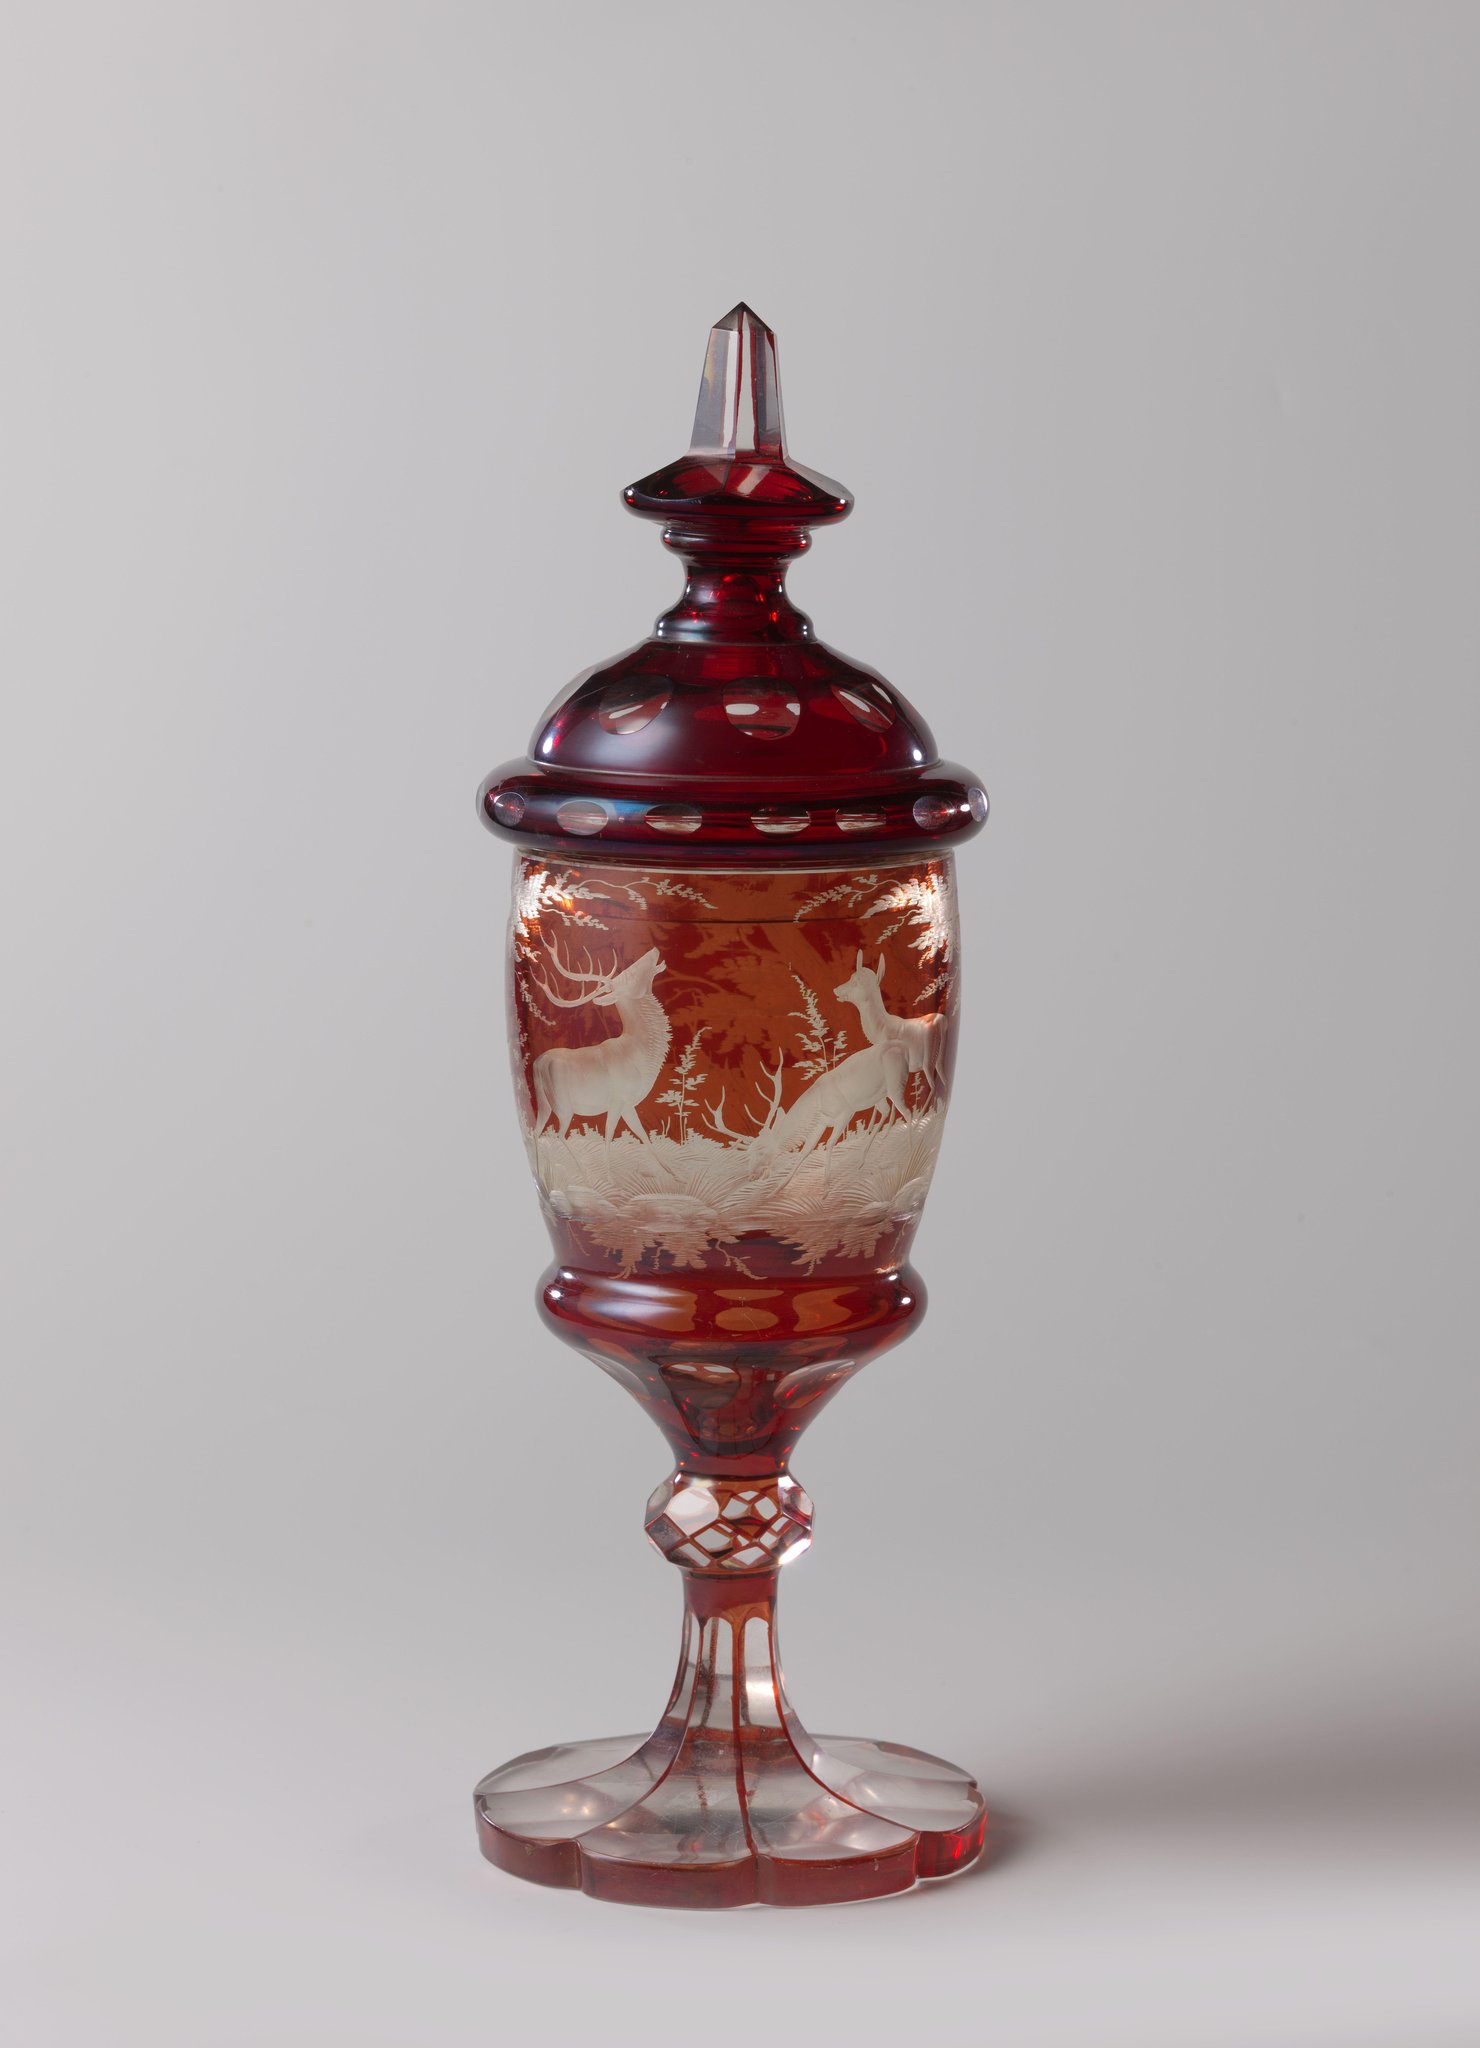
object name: lid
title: Deksel van bokaal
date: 1920-1940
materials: glass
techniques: glassblowing, grinding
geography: steinschönau